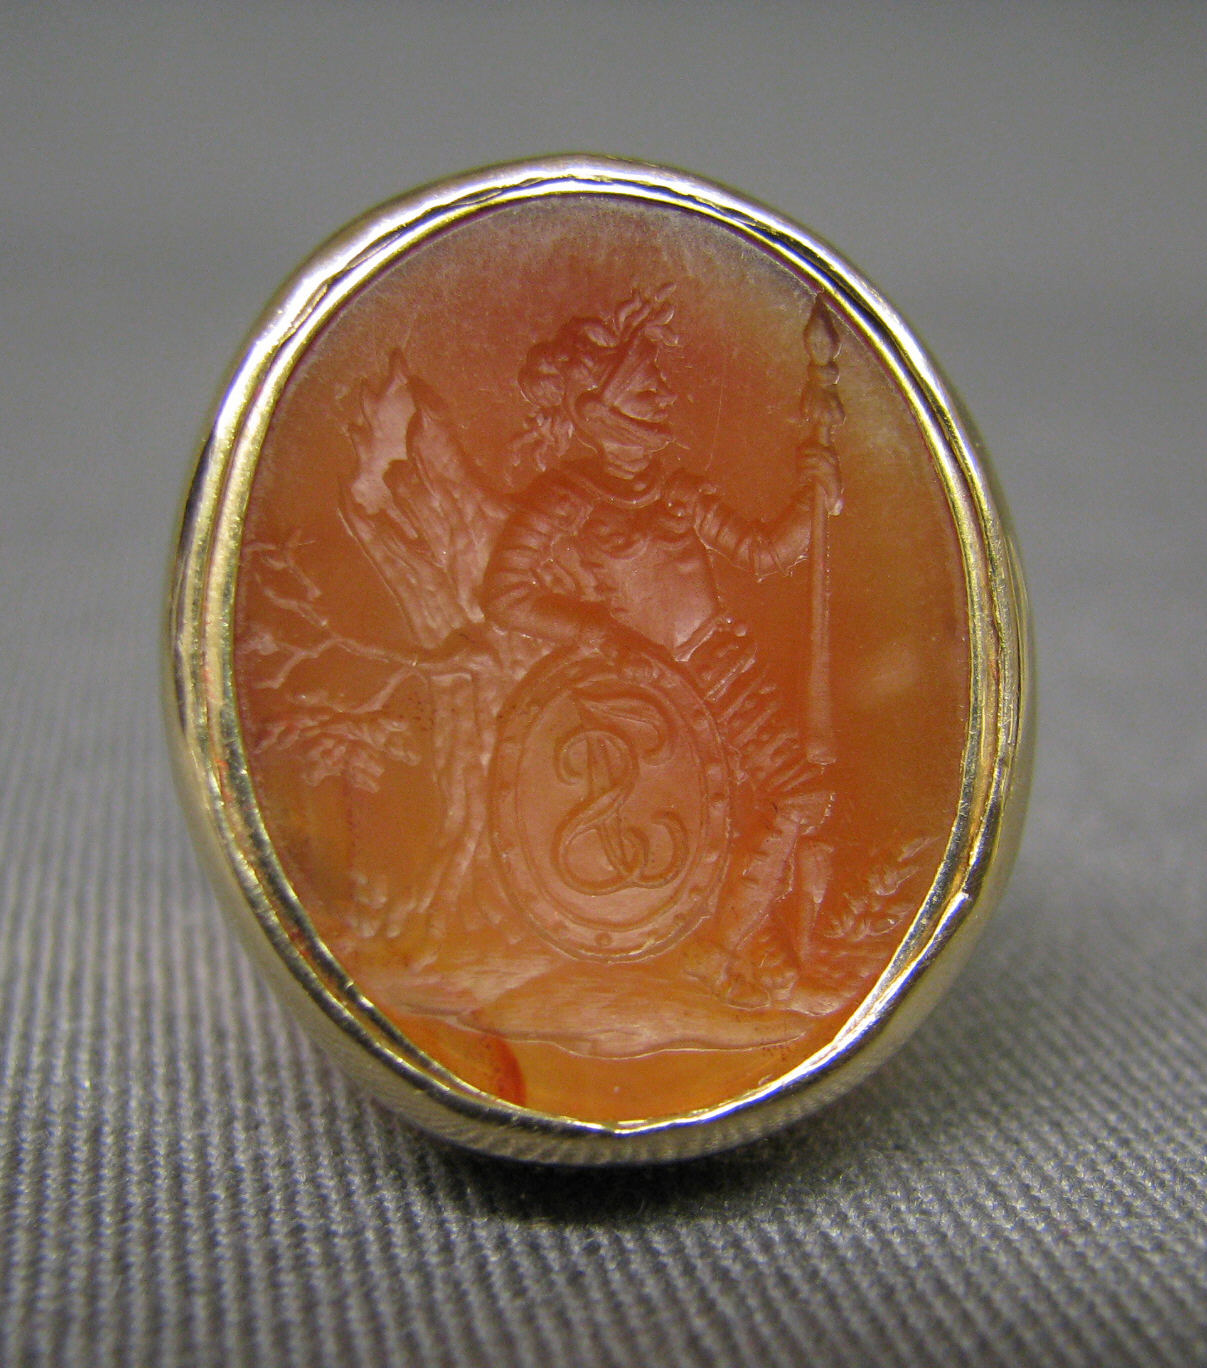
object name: ring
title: Knight supporting a shield and leaning against a tree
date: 1701-1900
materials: gemstone, gold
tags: shields,spears,trees,knights